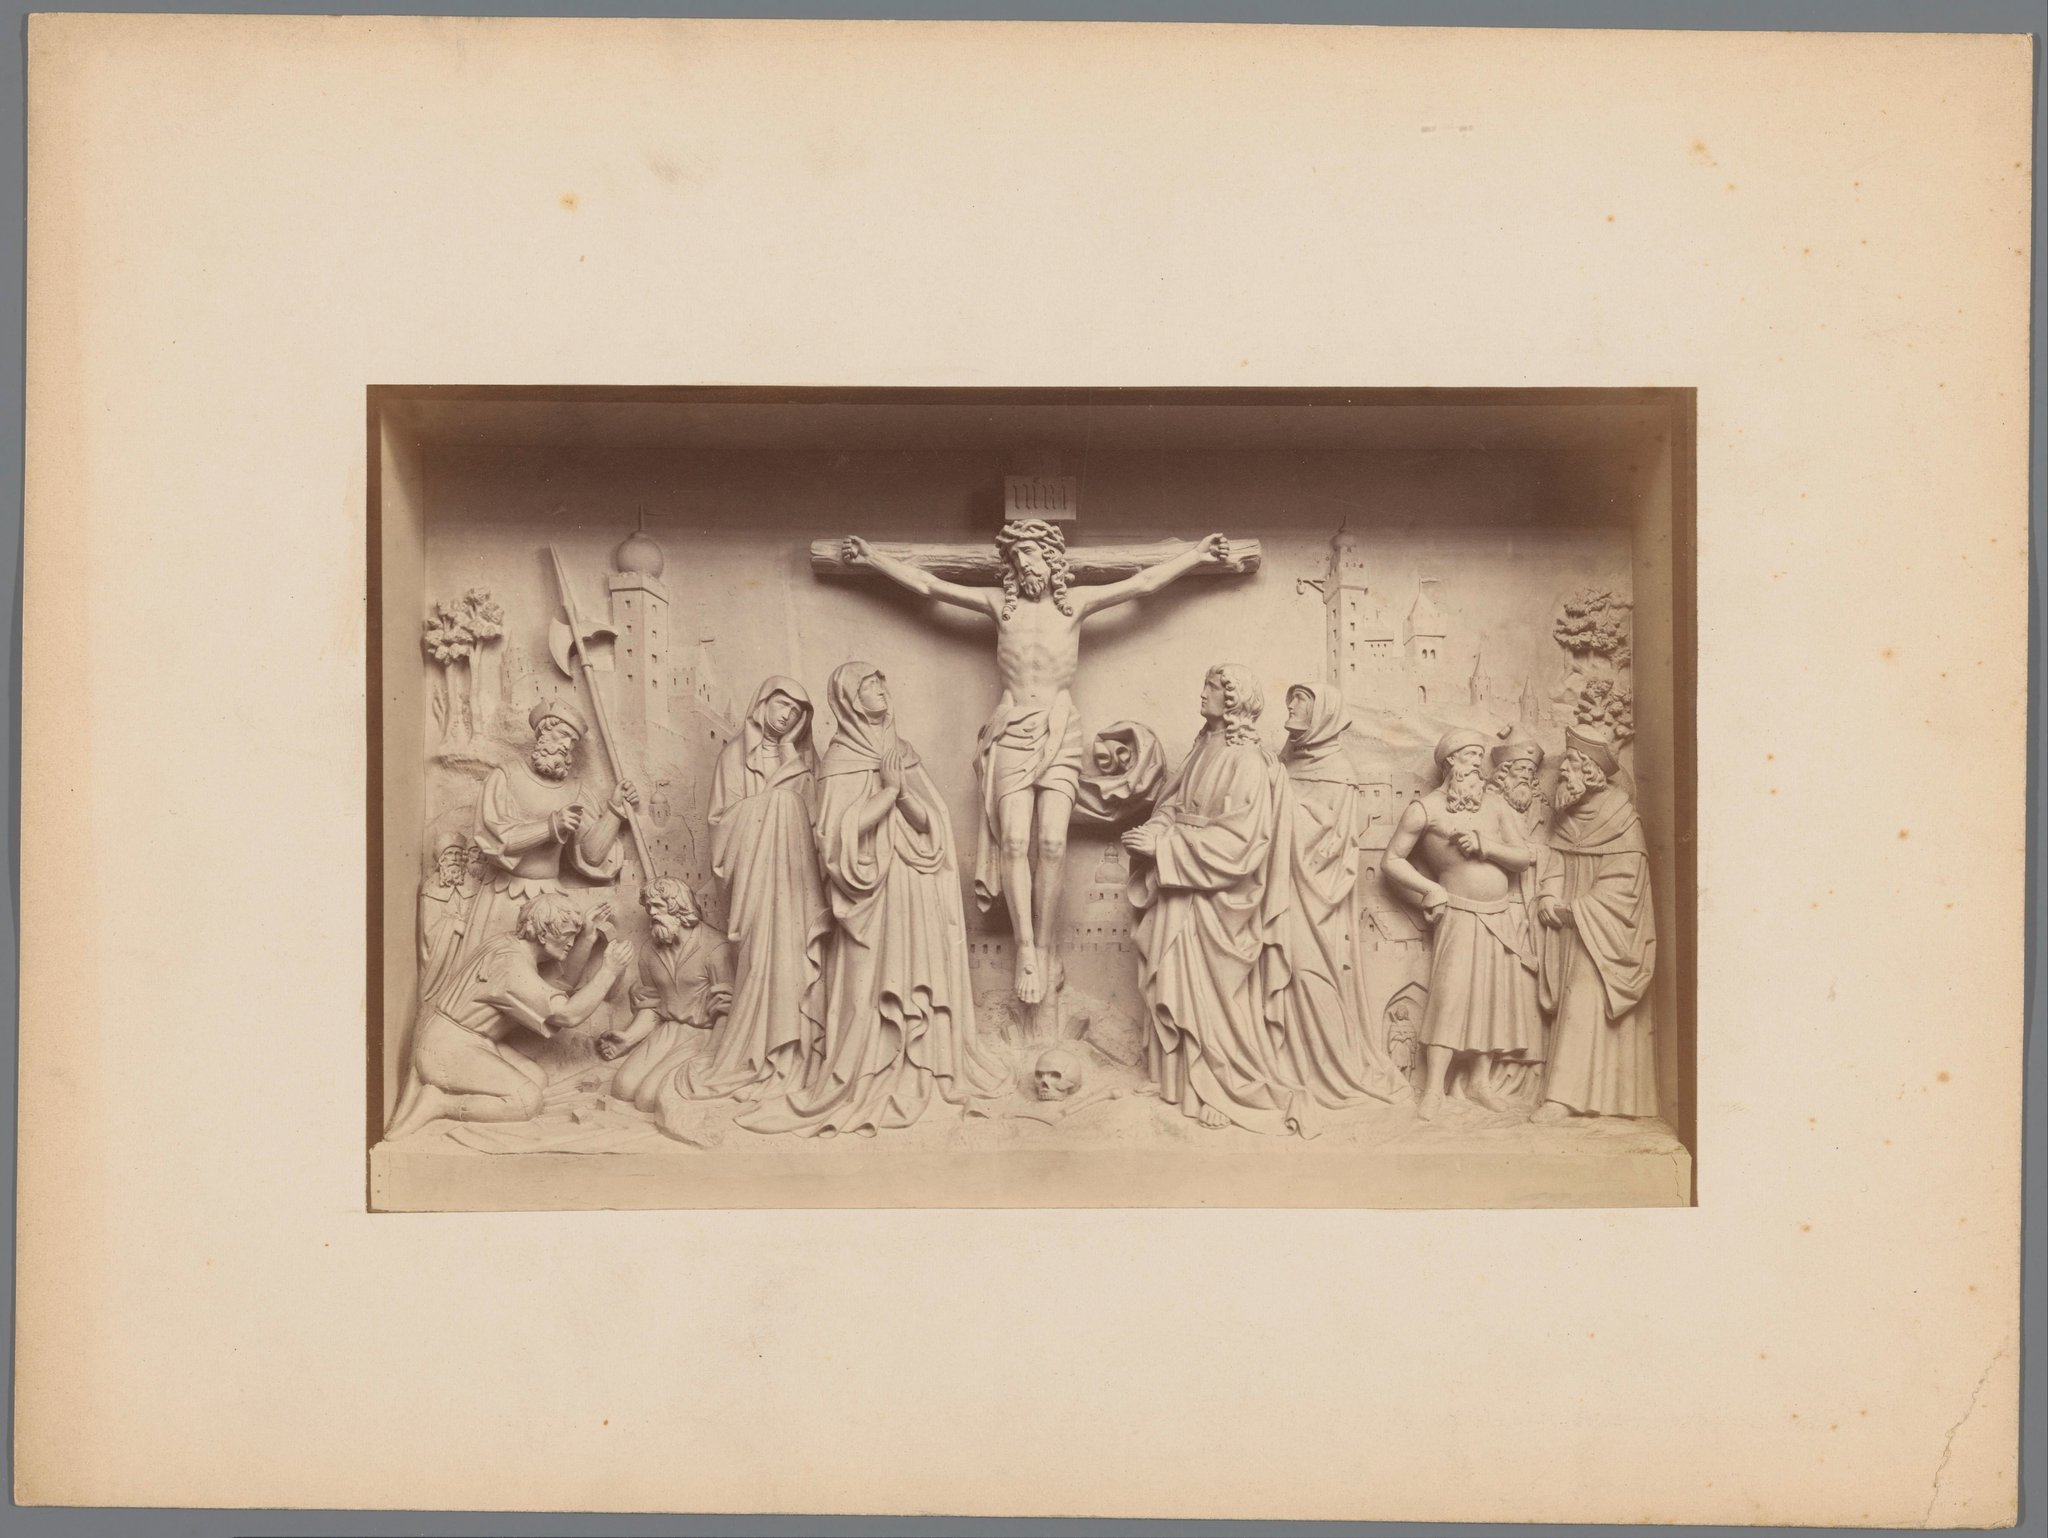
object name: photograph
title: Reliëf met de kruisiging van Christus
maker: Anonymous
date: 1875-1900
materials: cardboard, photographic support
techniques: albumen print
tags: soldiers throwing dice for christ's seamless garment ~ christ's death on the cross, the crucifixion of christ: christ's death on the cross; golgotha (matthew 27:45-58; mark 15:33-45; luke 23:44-52; john 19:25-38), sculpture (+ relief ~ sculpture)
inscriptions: collector's mark: Lugt 3937